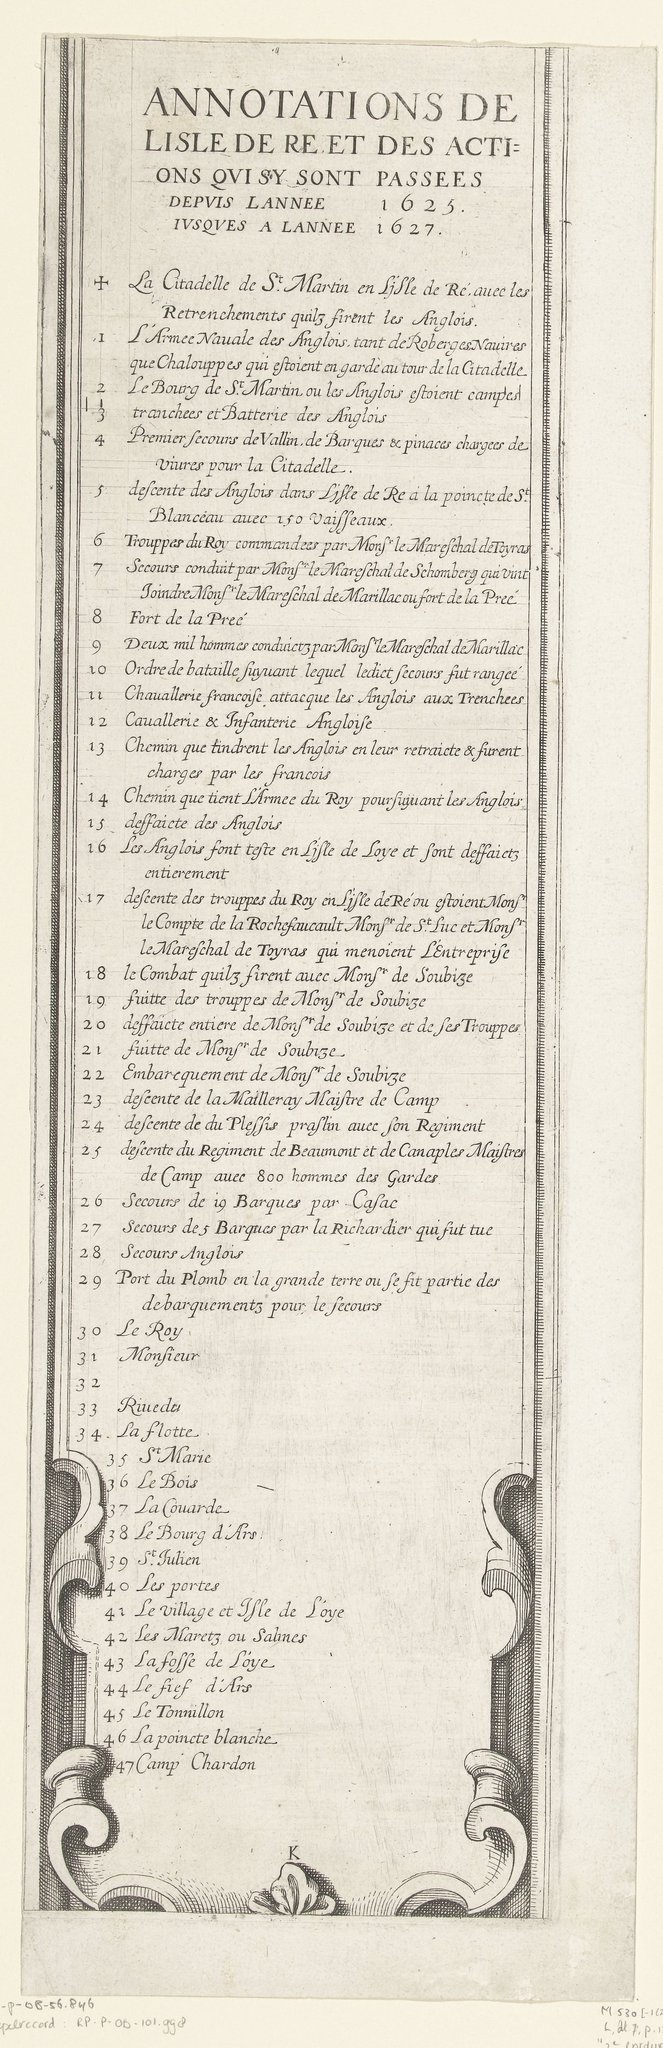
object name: print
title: Beleg van Saint Martin op het Île de Ré, juli-november 1627 (tekst, deel linksonder)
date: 1629-1631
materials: paper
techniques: engraving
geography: france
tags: ile de ré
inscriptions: collector's mark: Lugt 240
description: Zestiende deel (tekst, deel linksonder) van een prent van het beleg van de citadel Saint Martin op het Île de Ré in 1627, dat werd uitgevoerd door Engelse troepen onder leiding van de hertog van Buckingham en werd beëindigd door Franse troepen onder leiding van kardinaal Richelieu. Op dit blad de legenda bij de centrale kaart, in het Frans.